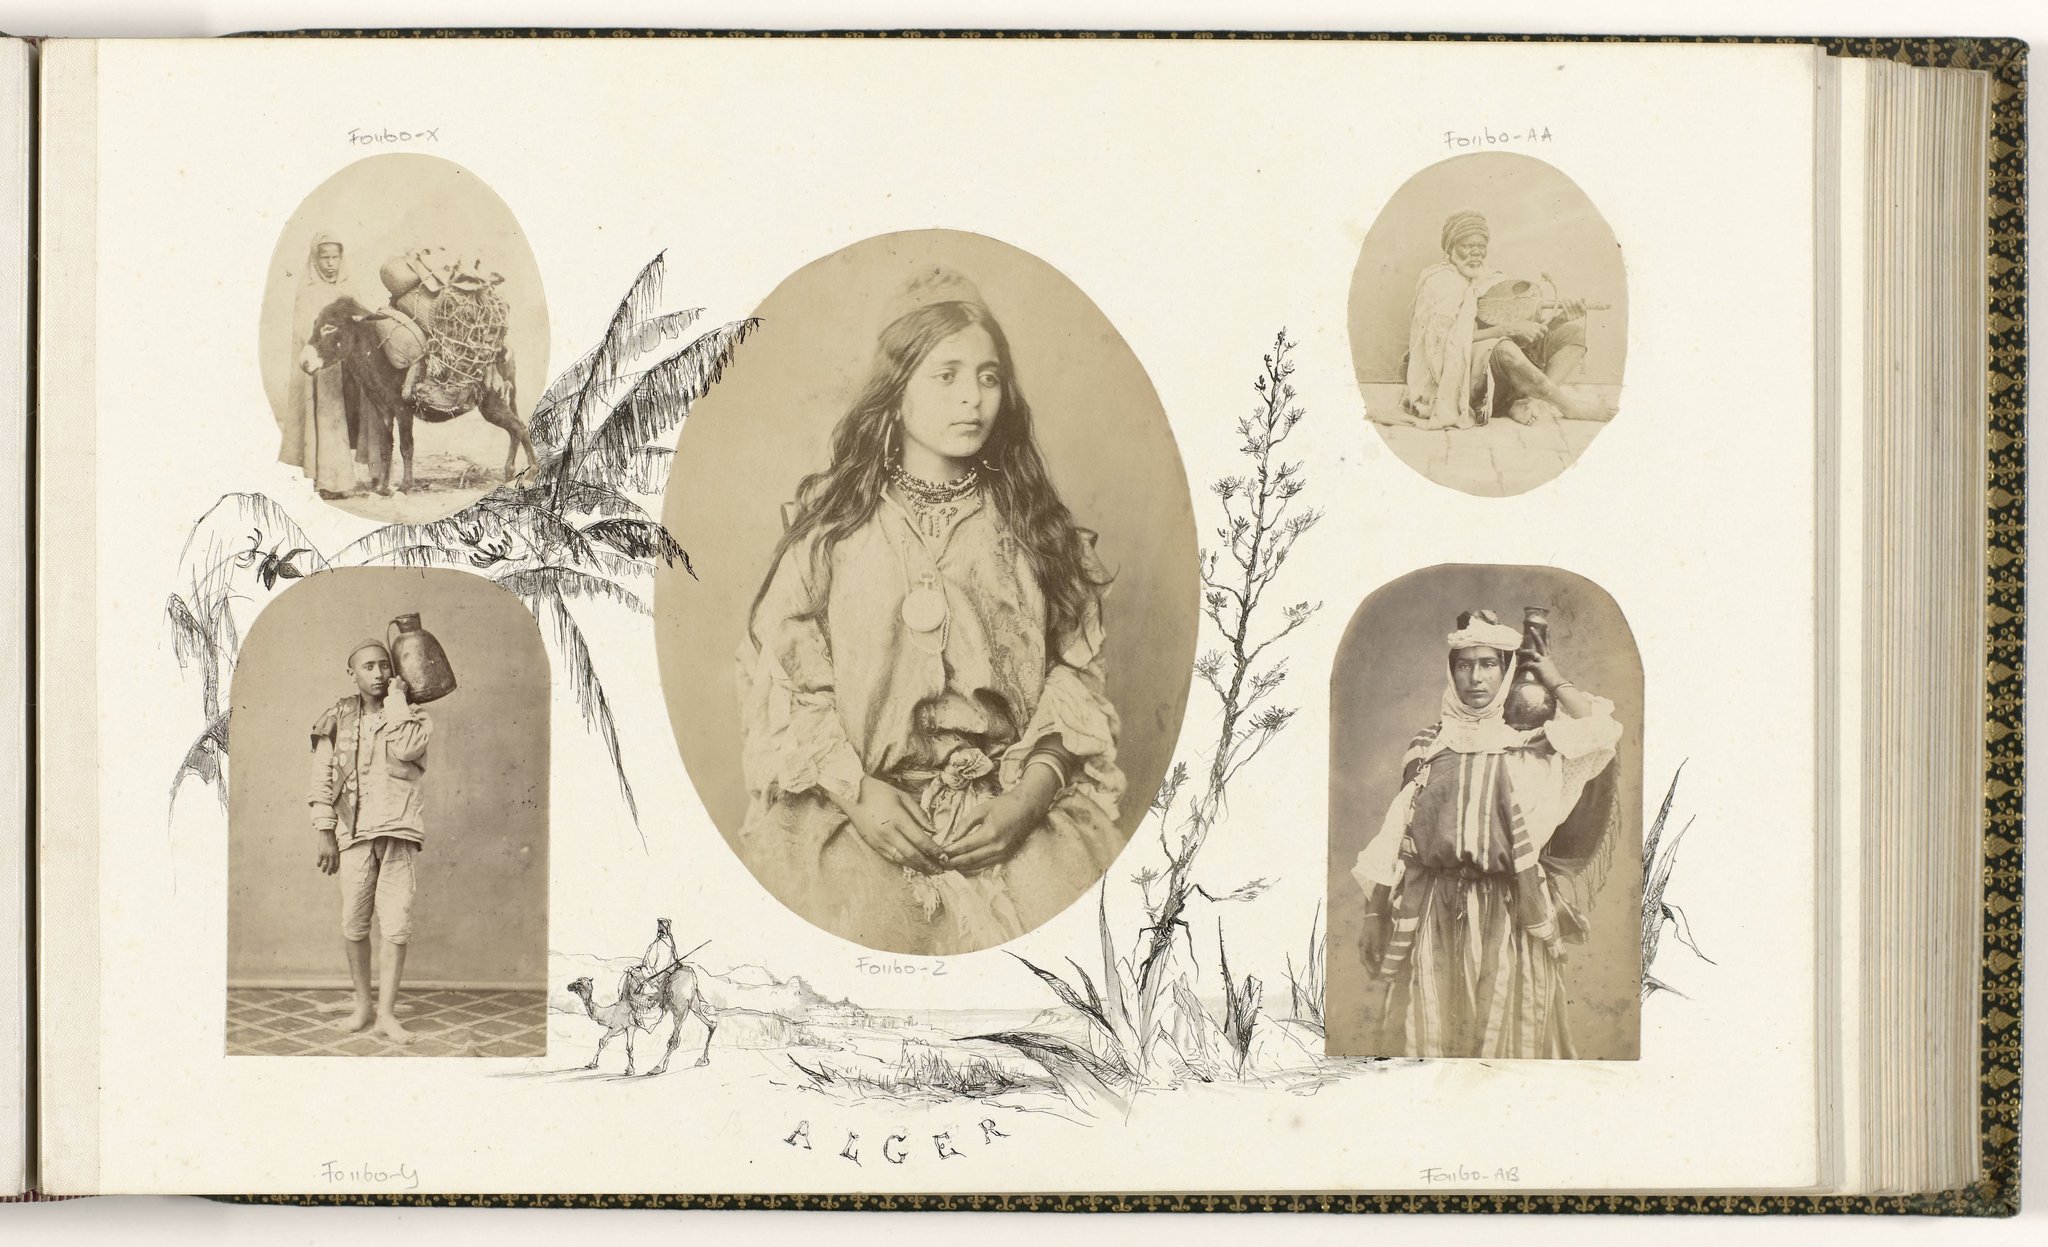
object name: photograph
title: Portret van een onbekende jongen naast een beladen ezel, mogelijk in Algiers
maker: Anonymous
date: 1865-1875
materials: paper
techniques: albumen print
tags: ass, donkey, boy (child between toddler and youth), anonymous historical person portrayed